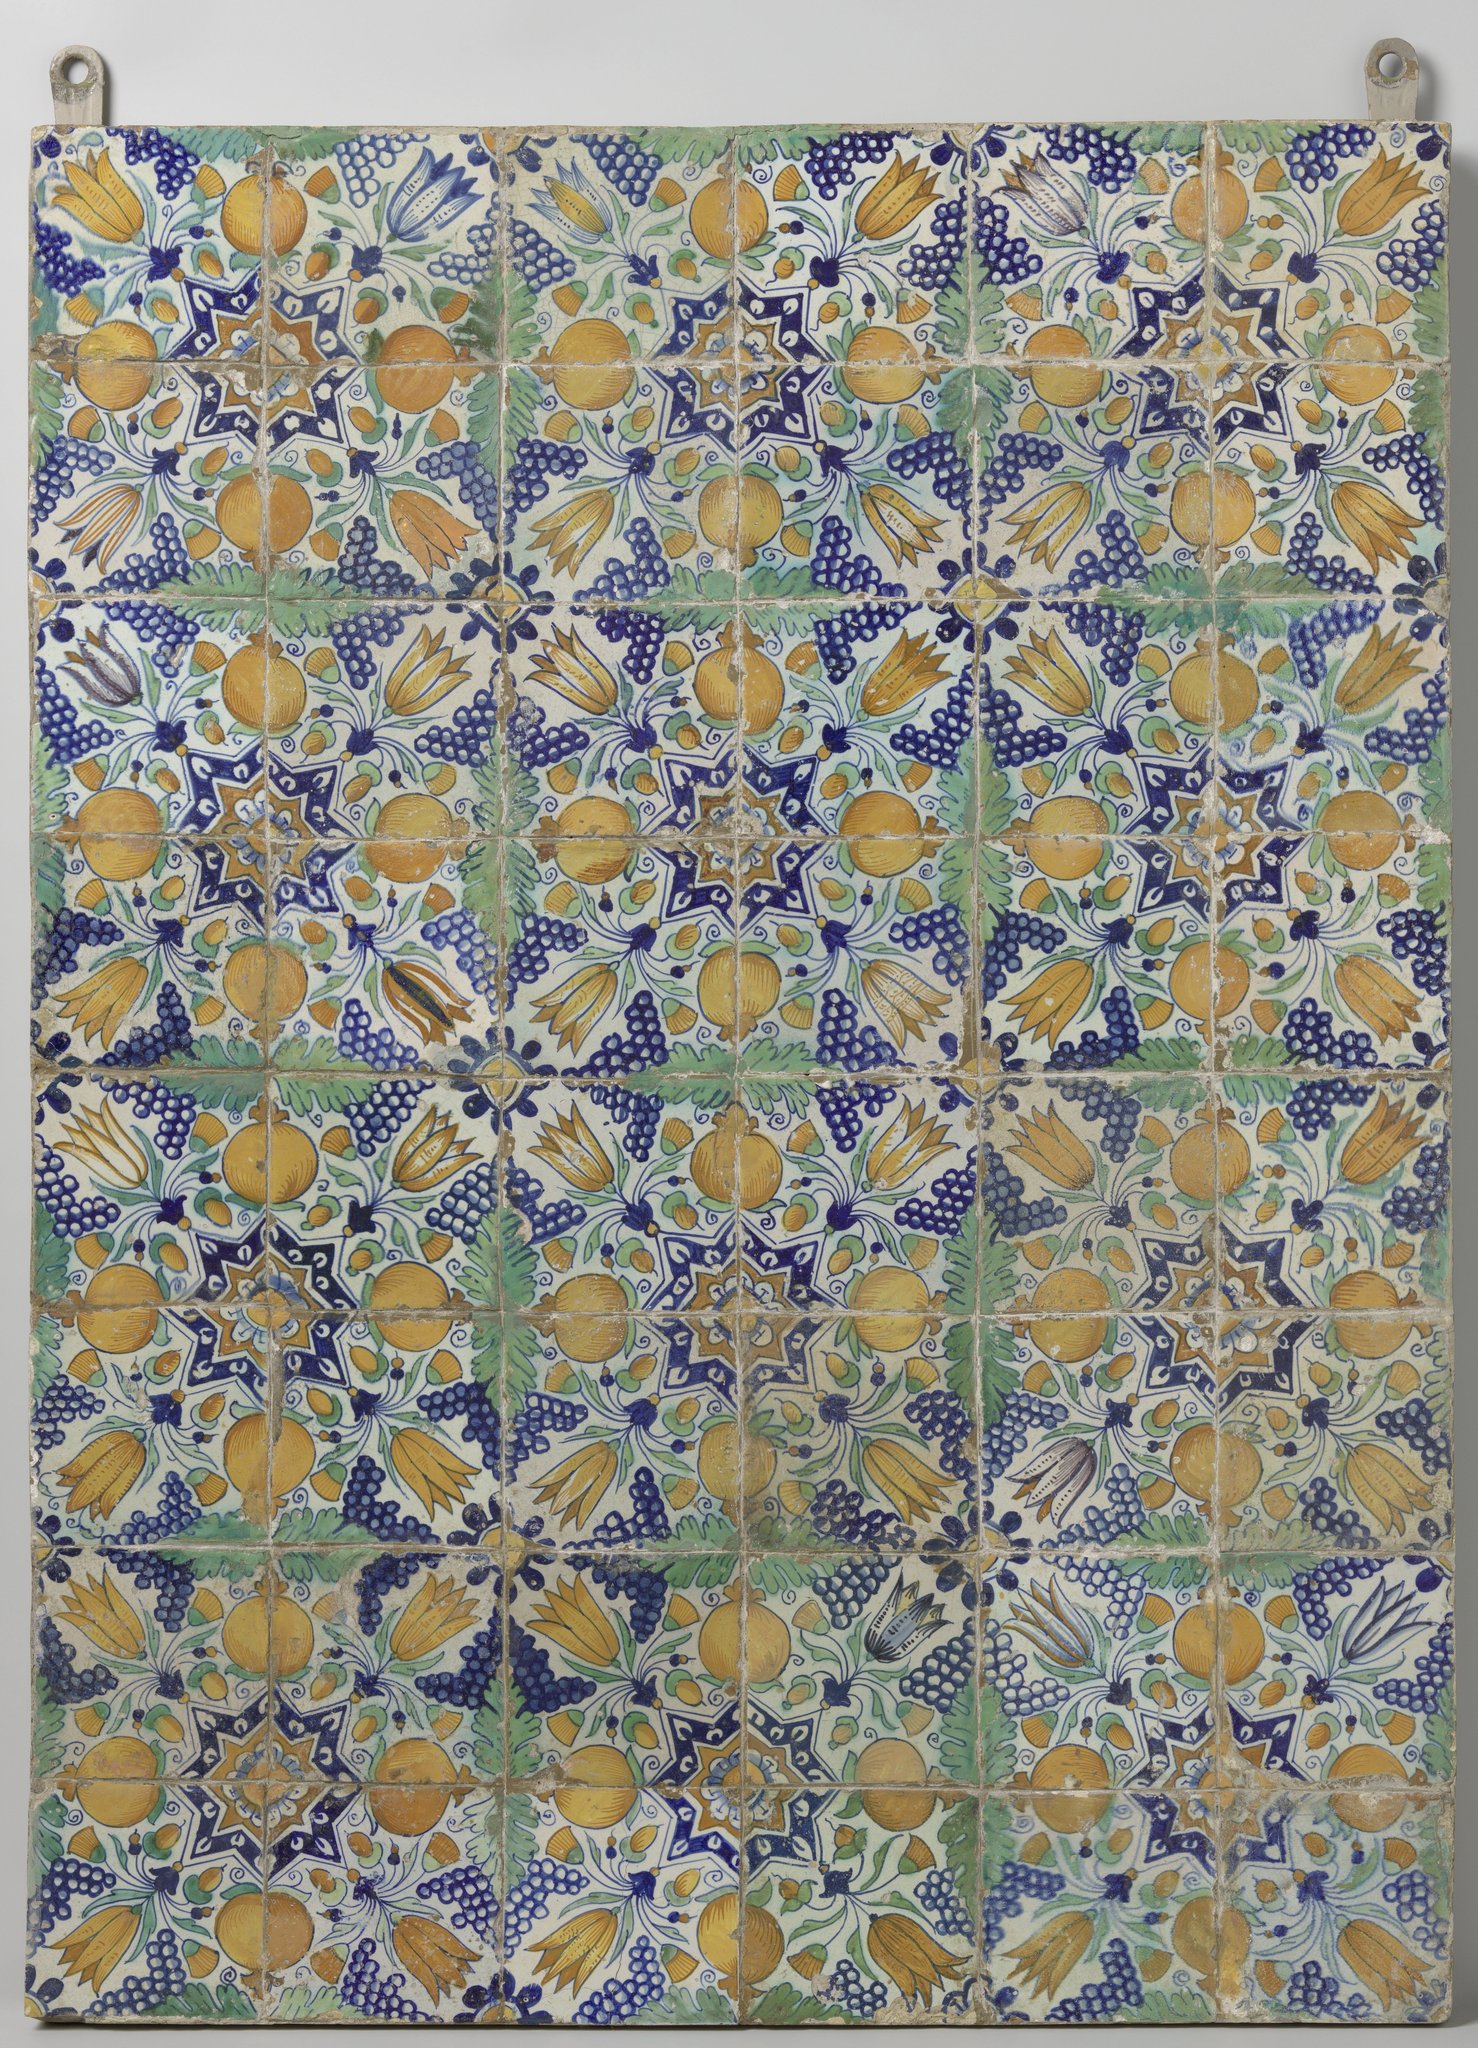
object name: tile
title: Veld van achtenveertig tegels met patroon van granaatappels, druiventrossen en tulpen rond een ster die steeds wordt gevormd door vier tegels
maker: Anonymous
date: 1600-1625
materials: earthenware, glaze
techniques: maiolica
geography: netherlands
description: Veld van achtenveertig tegels (8 x 6) met een veelkleurig (blauw, groen, geel, oranje en paars) patroon gevormd door vier tegels met granaatappels, druiventrossen en tulpen rond een ster.